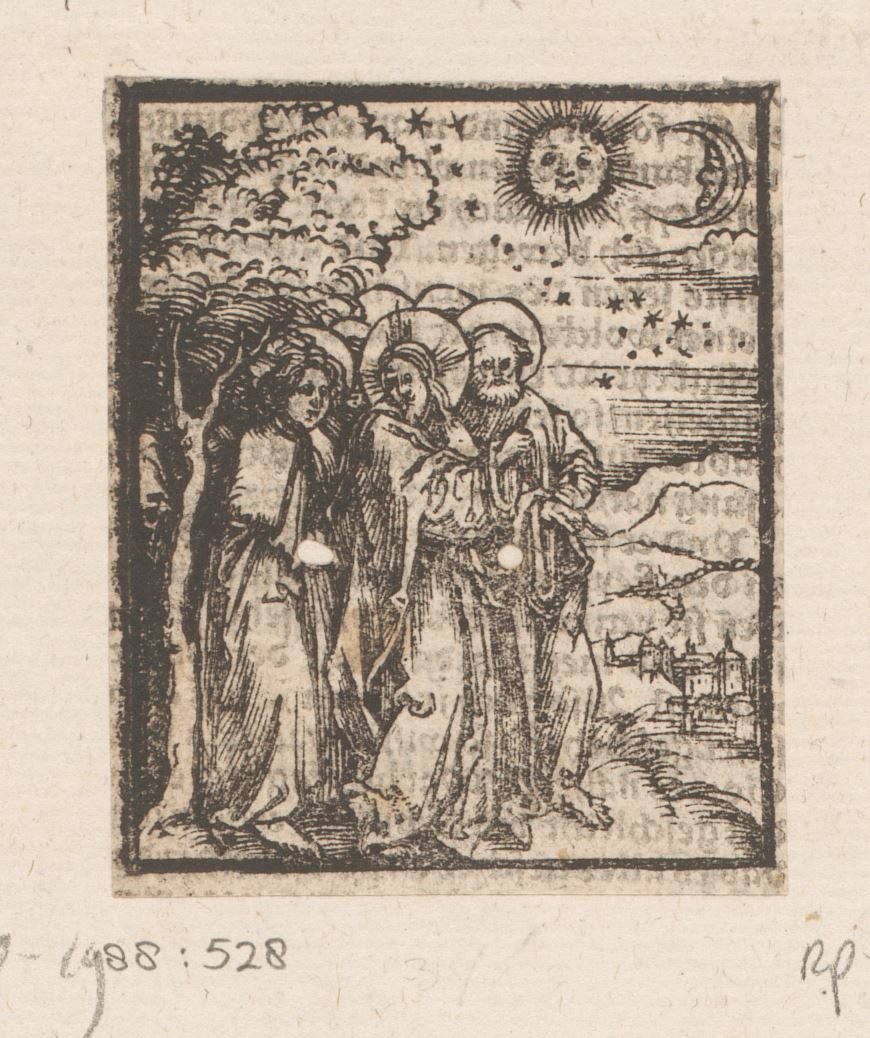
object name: book illustration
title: Christus wijst de discipelen op de hemellichamen die de val van Jerusalem voorspellen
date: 1536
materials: paper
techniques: woodcut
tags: signs in nature and in the sky prophesying the destruction of jerusalem (luke 21:25)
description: Prent afkomstig uit: Evangelia und Epistel. Neurenberg: Hans Guldenmund, 1536.